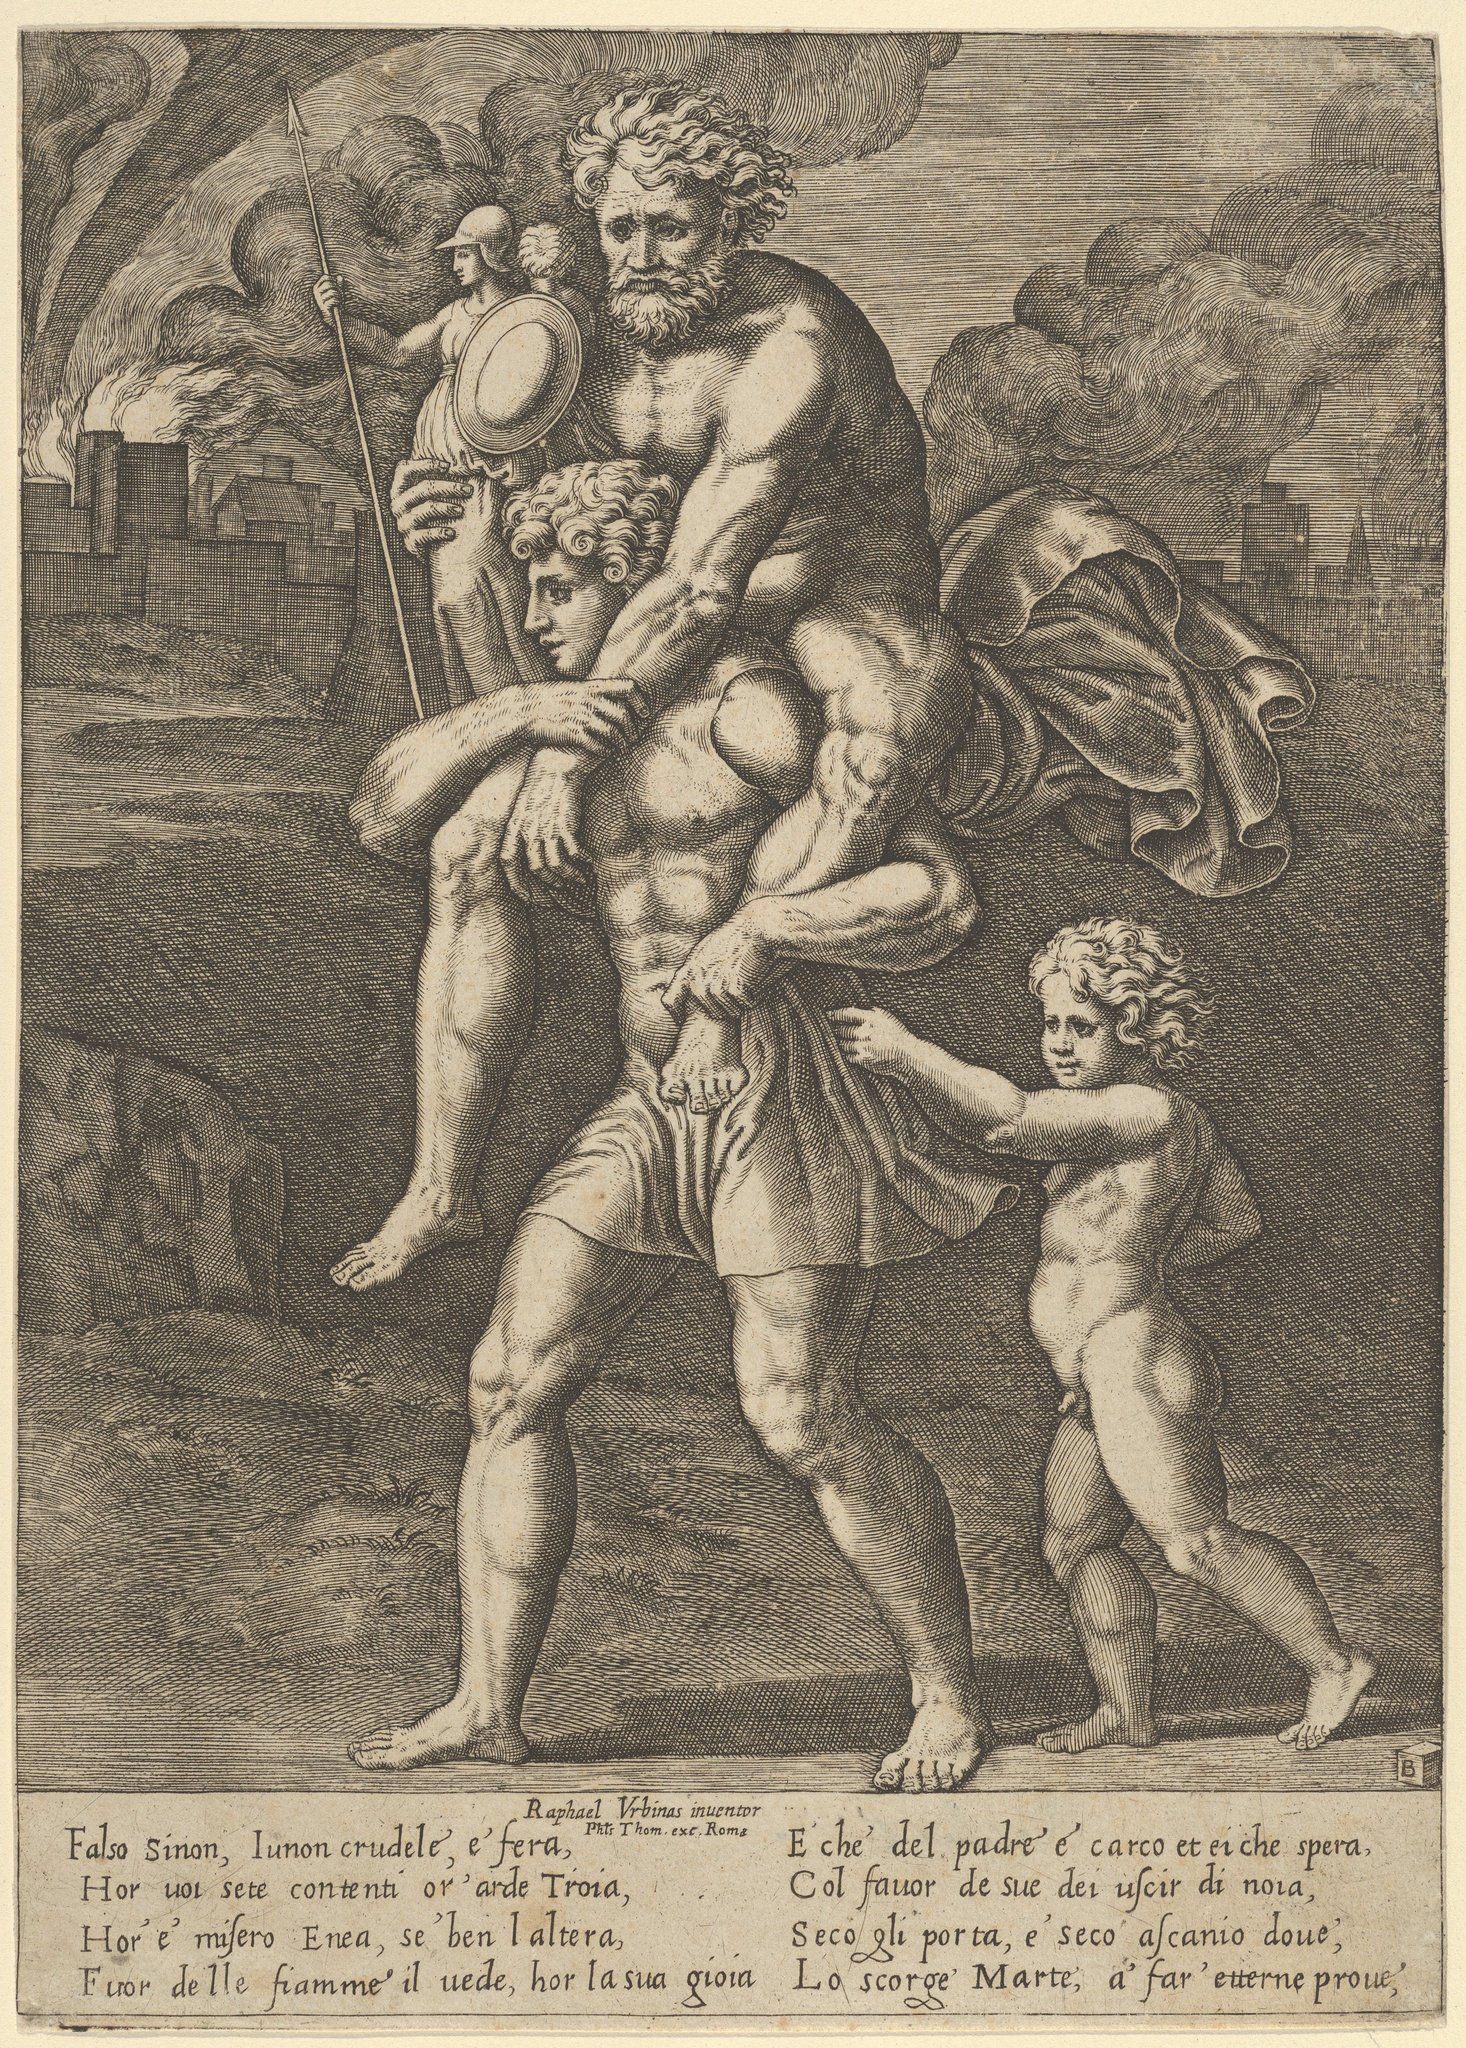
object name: print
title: Aeneas carrying Anchises on his shoulders while Troy burns in the background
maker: master of the die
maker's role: artist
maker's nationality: italian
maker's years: 1525-1560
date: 1530-1560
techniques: engraving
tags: boys,men,aeneas